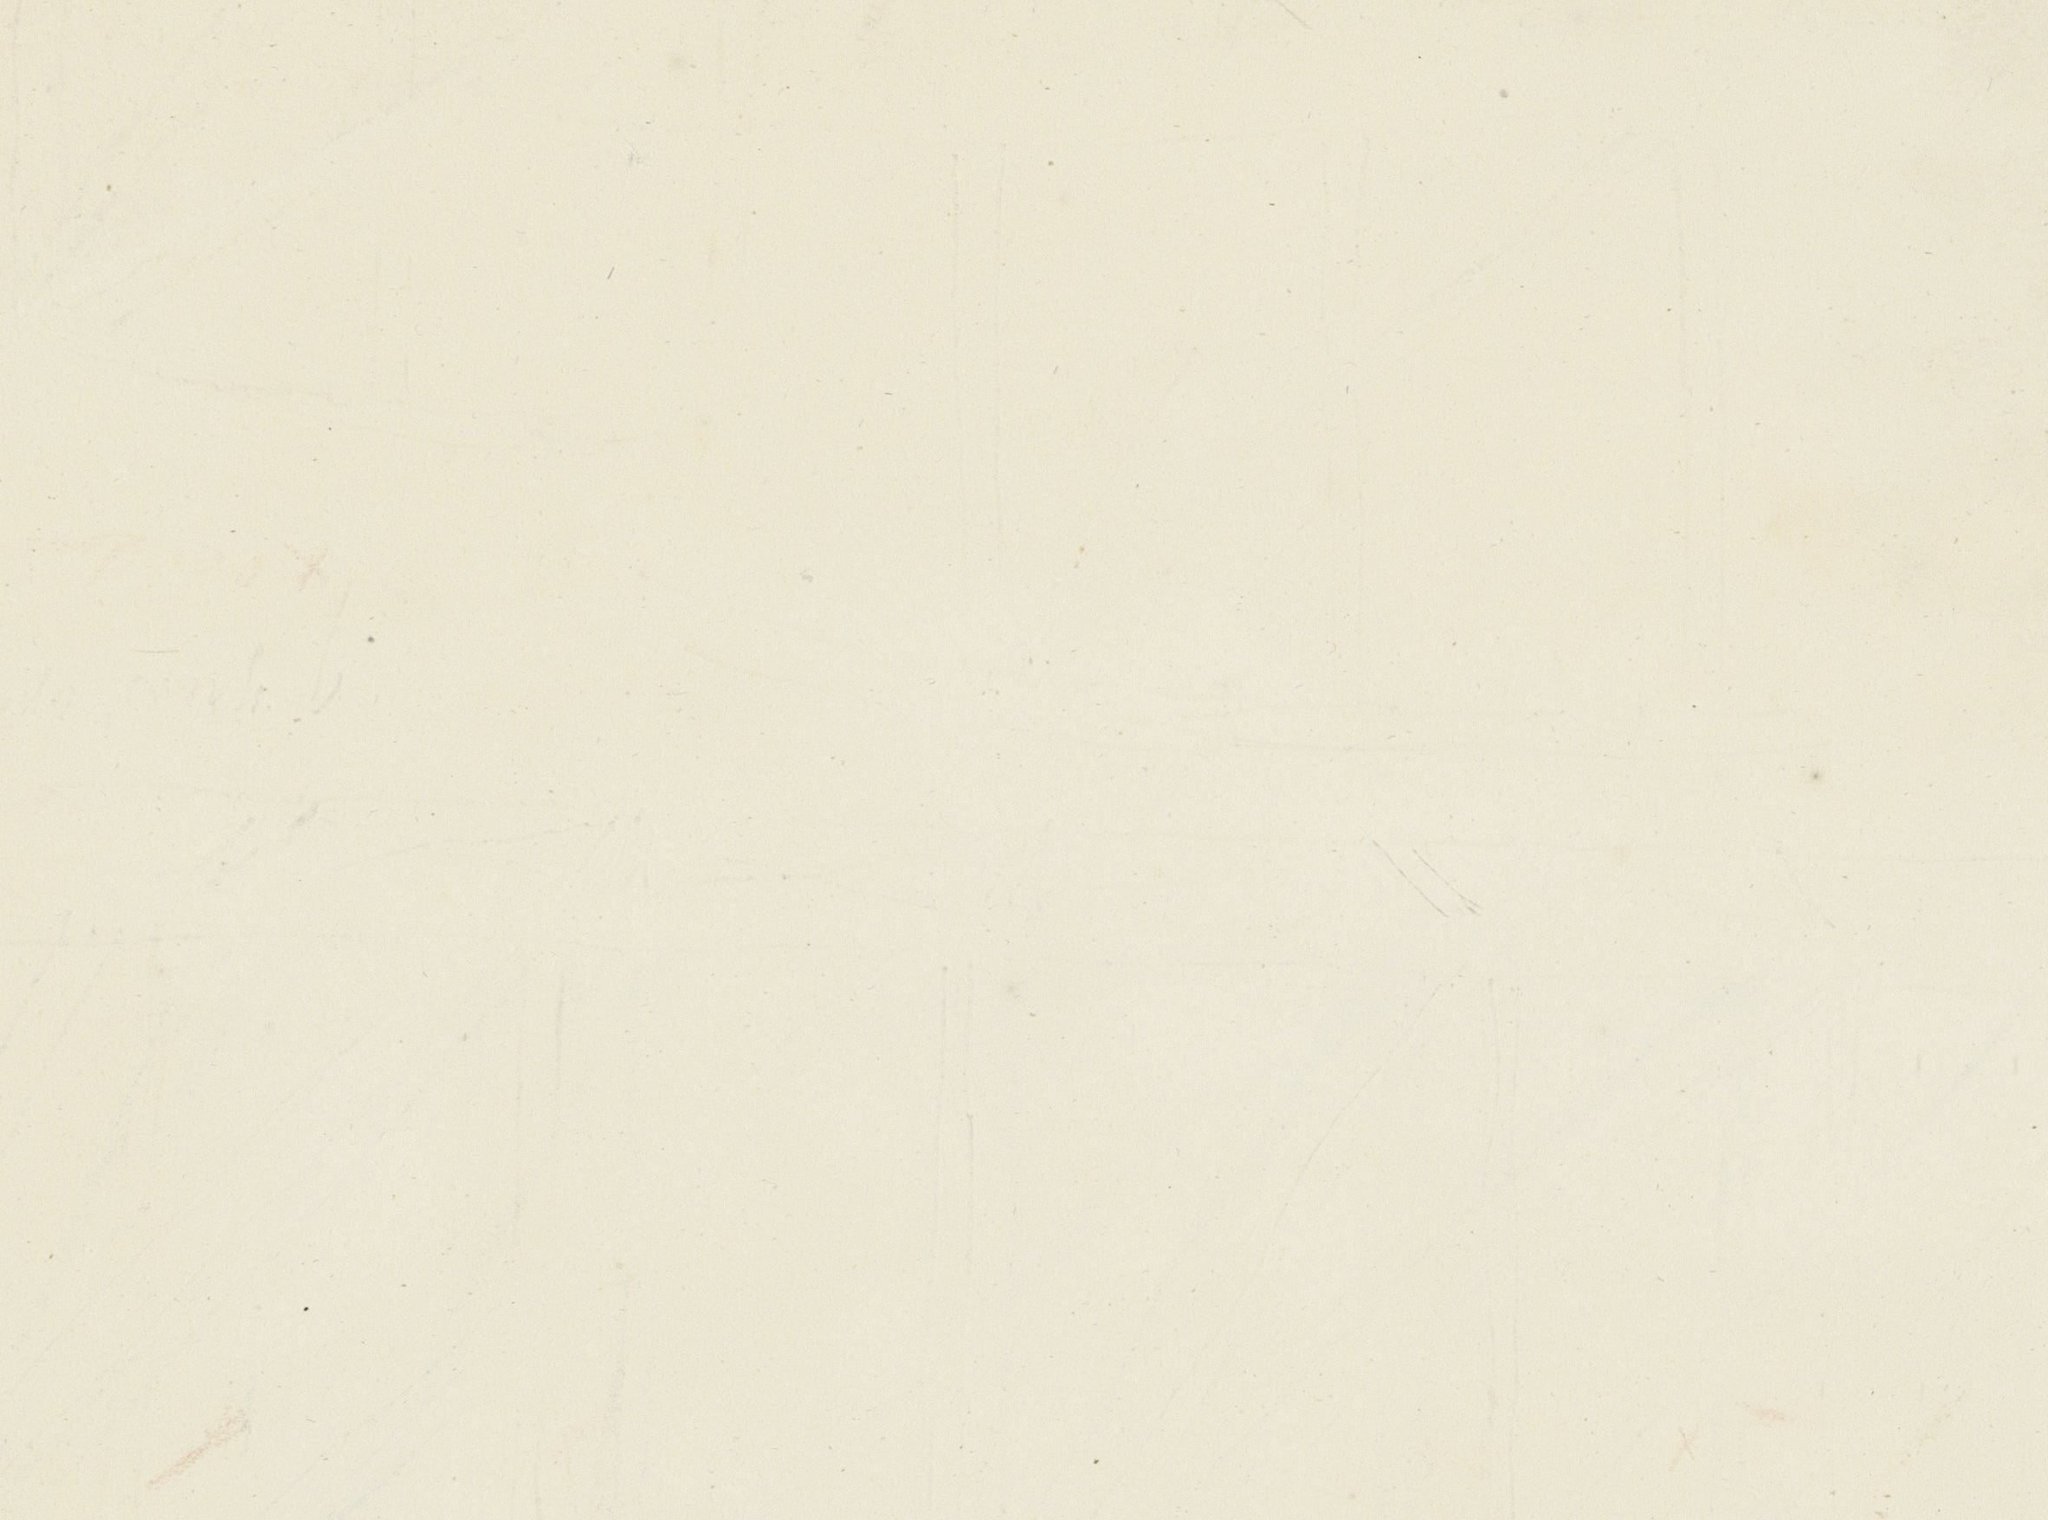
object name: sketchbook leaf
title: Studie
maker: petrus johannes schotel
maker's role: draughtsman, painter, print maker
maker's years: 1808-1865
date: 1825-1875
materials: paper, pencil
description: Blad 34 verso uit een schetsboek met 44 bladen.